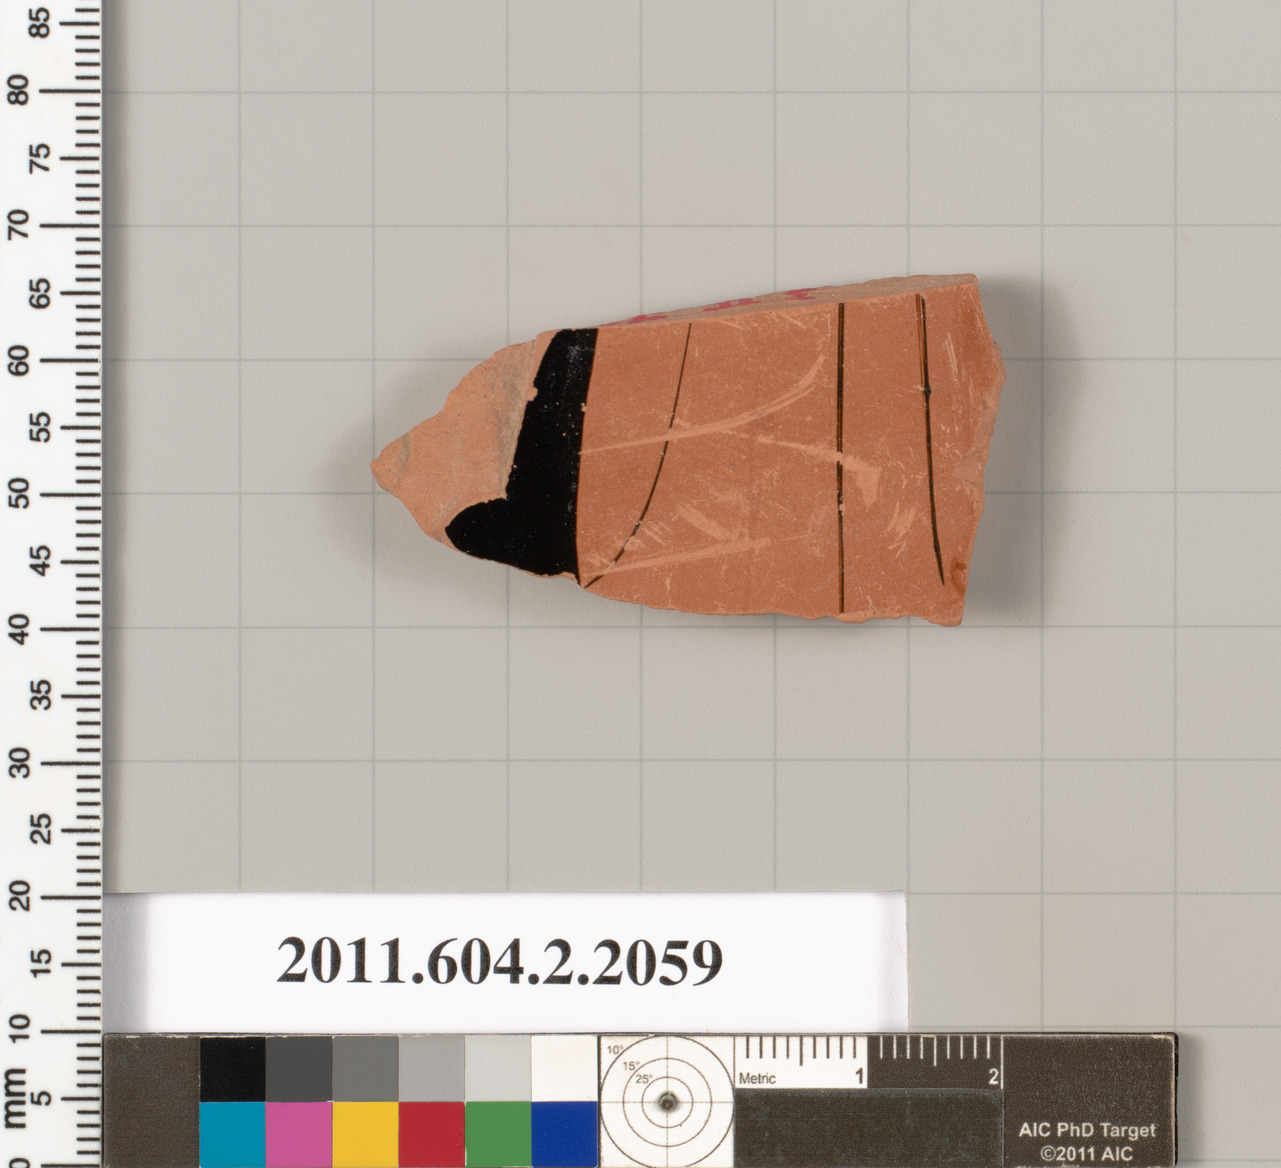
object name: krater fragment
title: Terracotta fragment of a krater (bowl for mixing wine and water)?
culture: greek, attic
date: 475-451 BCE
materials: terracotta